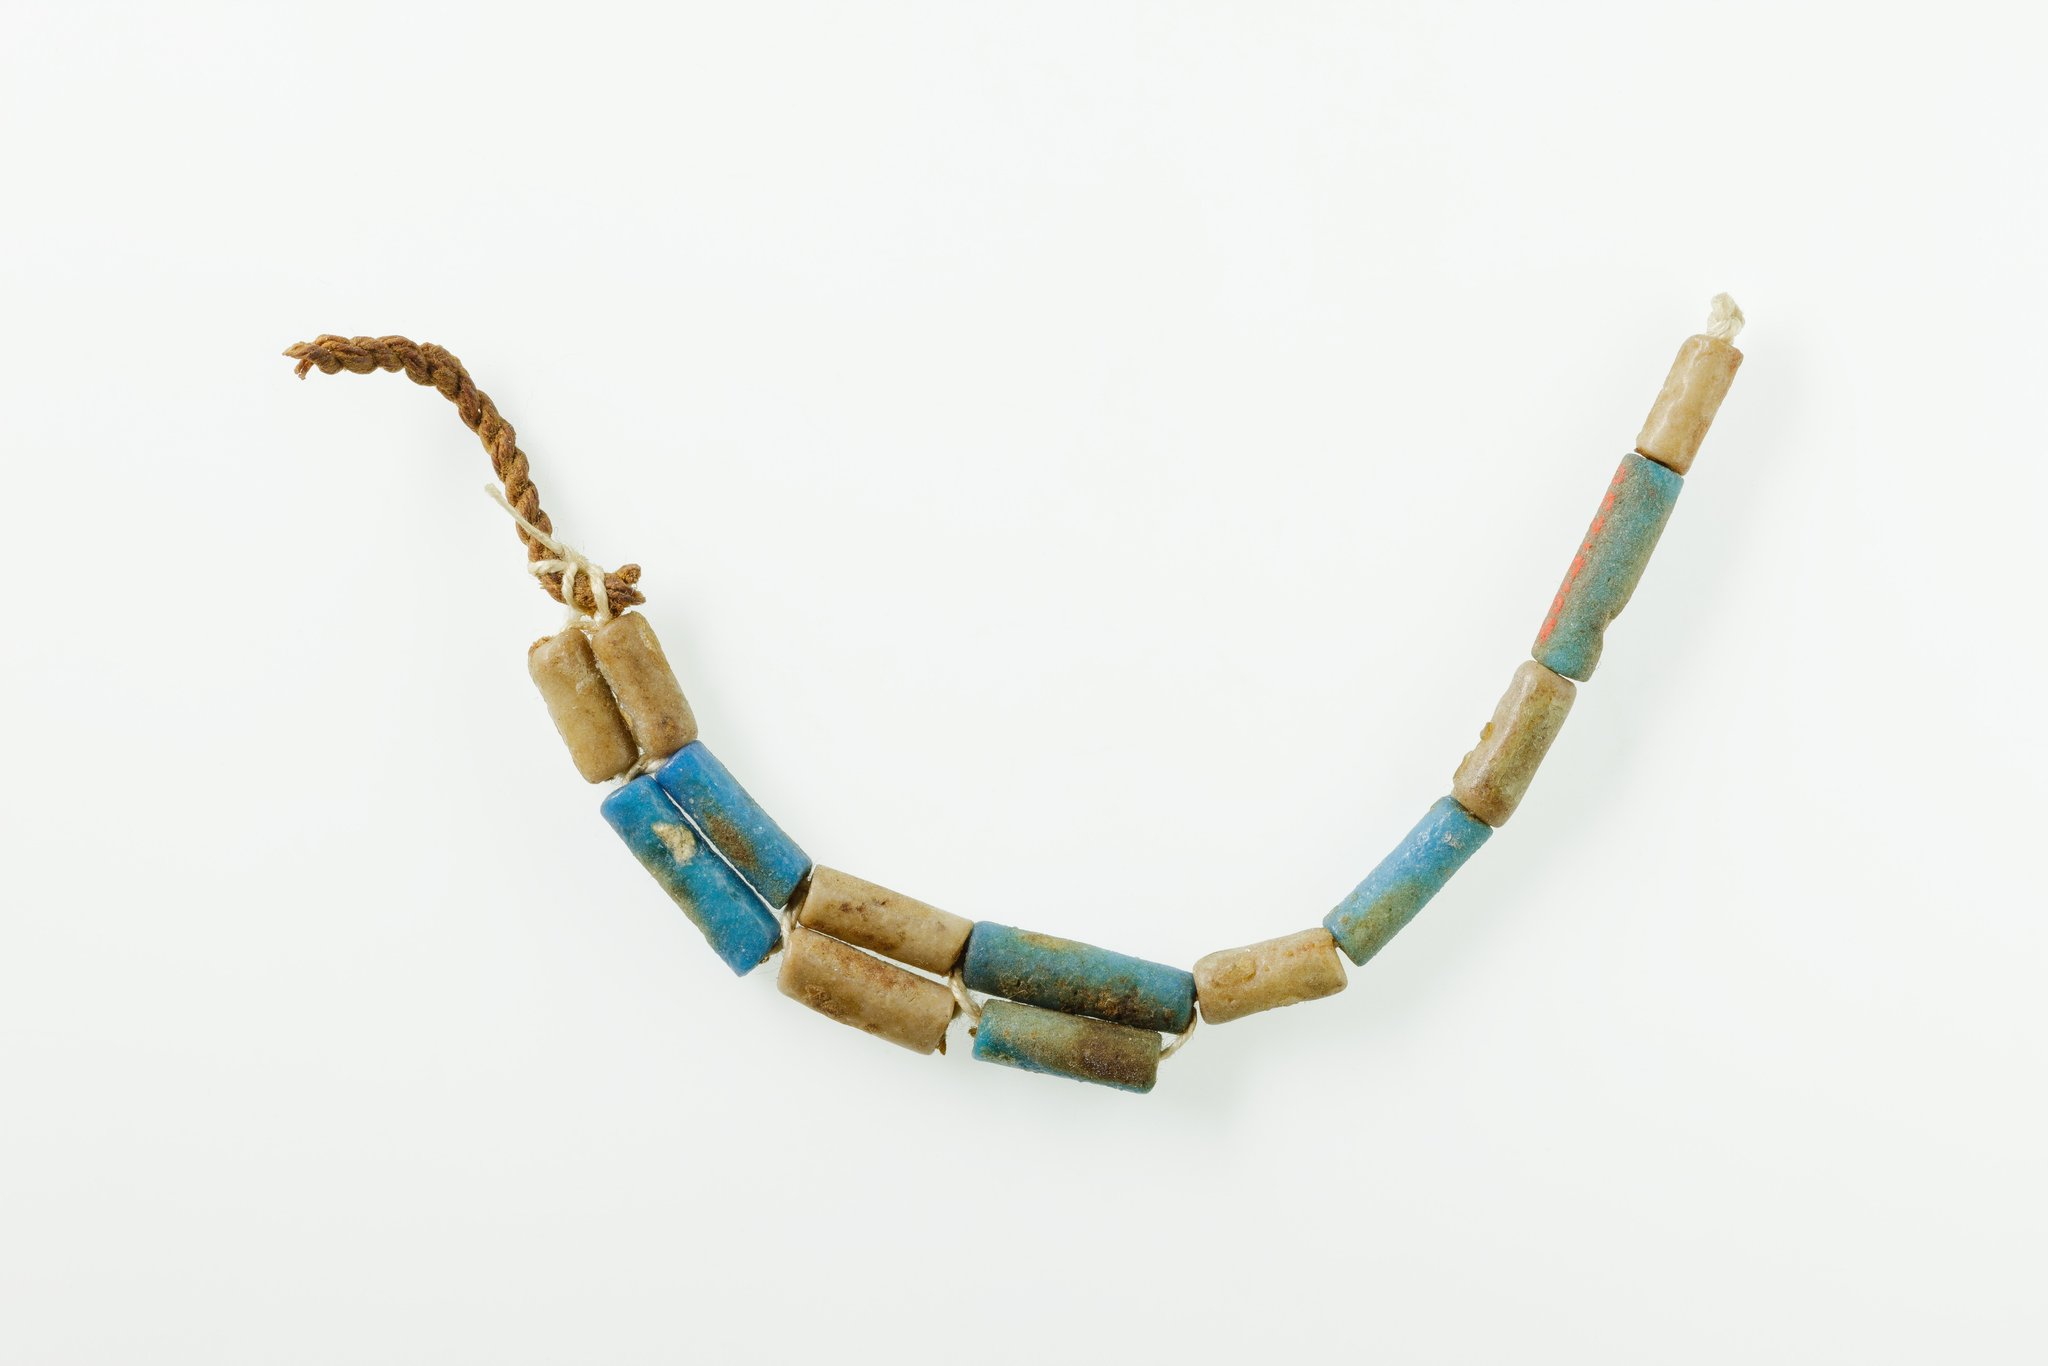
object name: anklet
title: Bead anklet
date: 2060-2010 BCE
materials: faience, linen, thread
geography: egypt